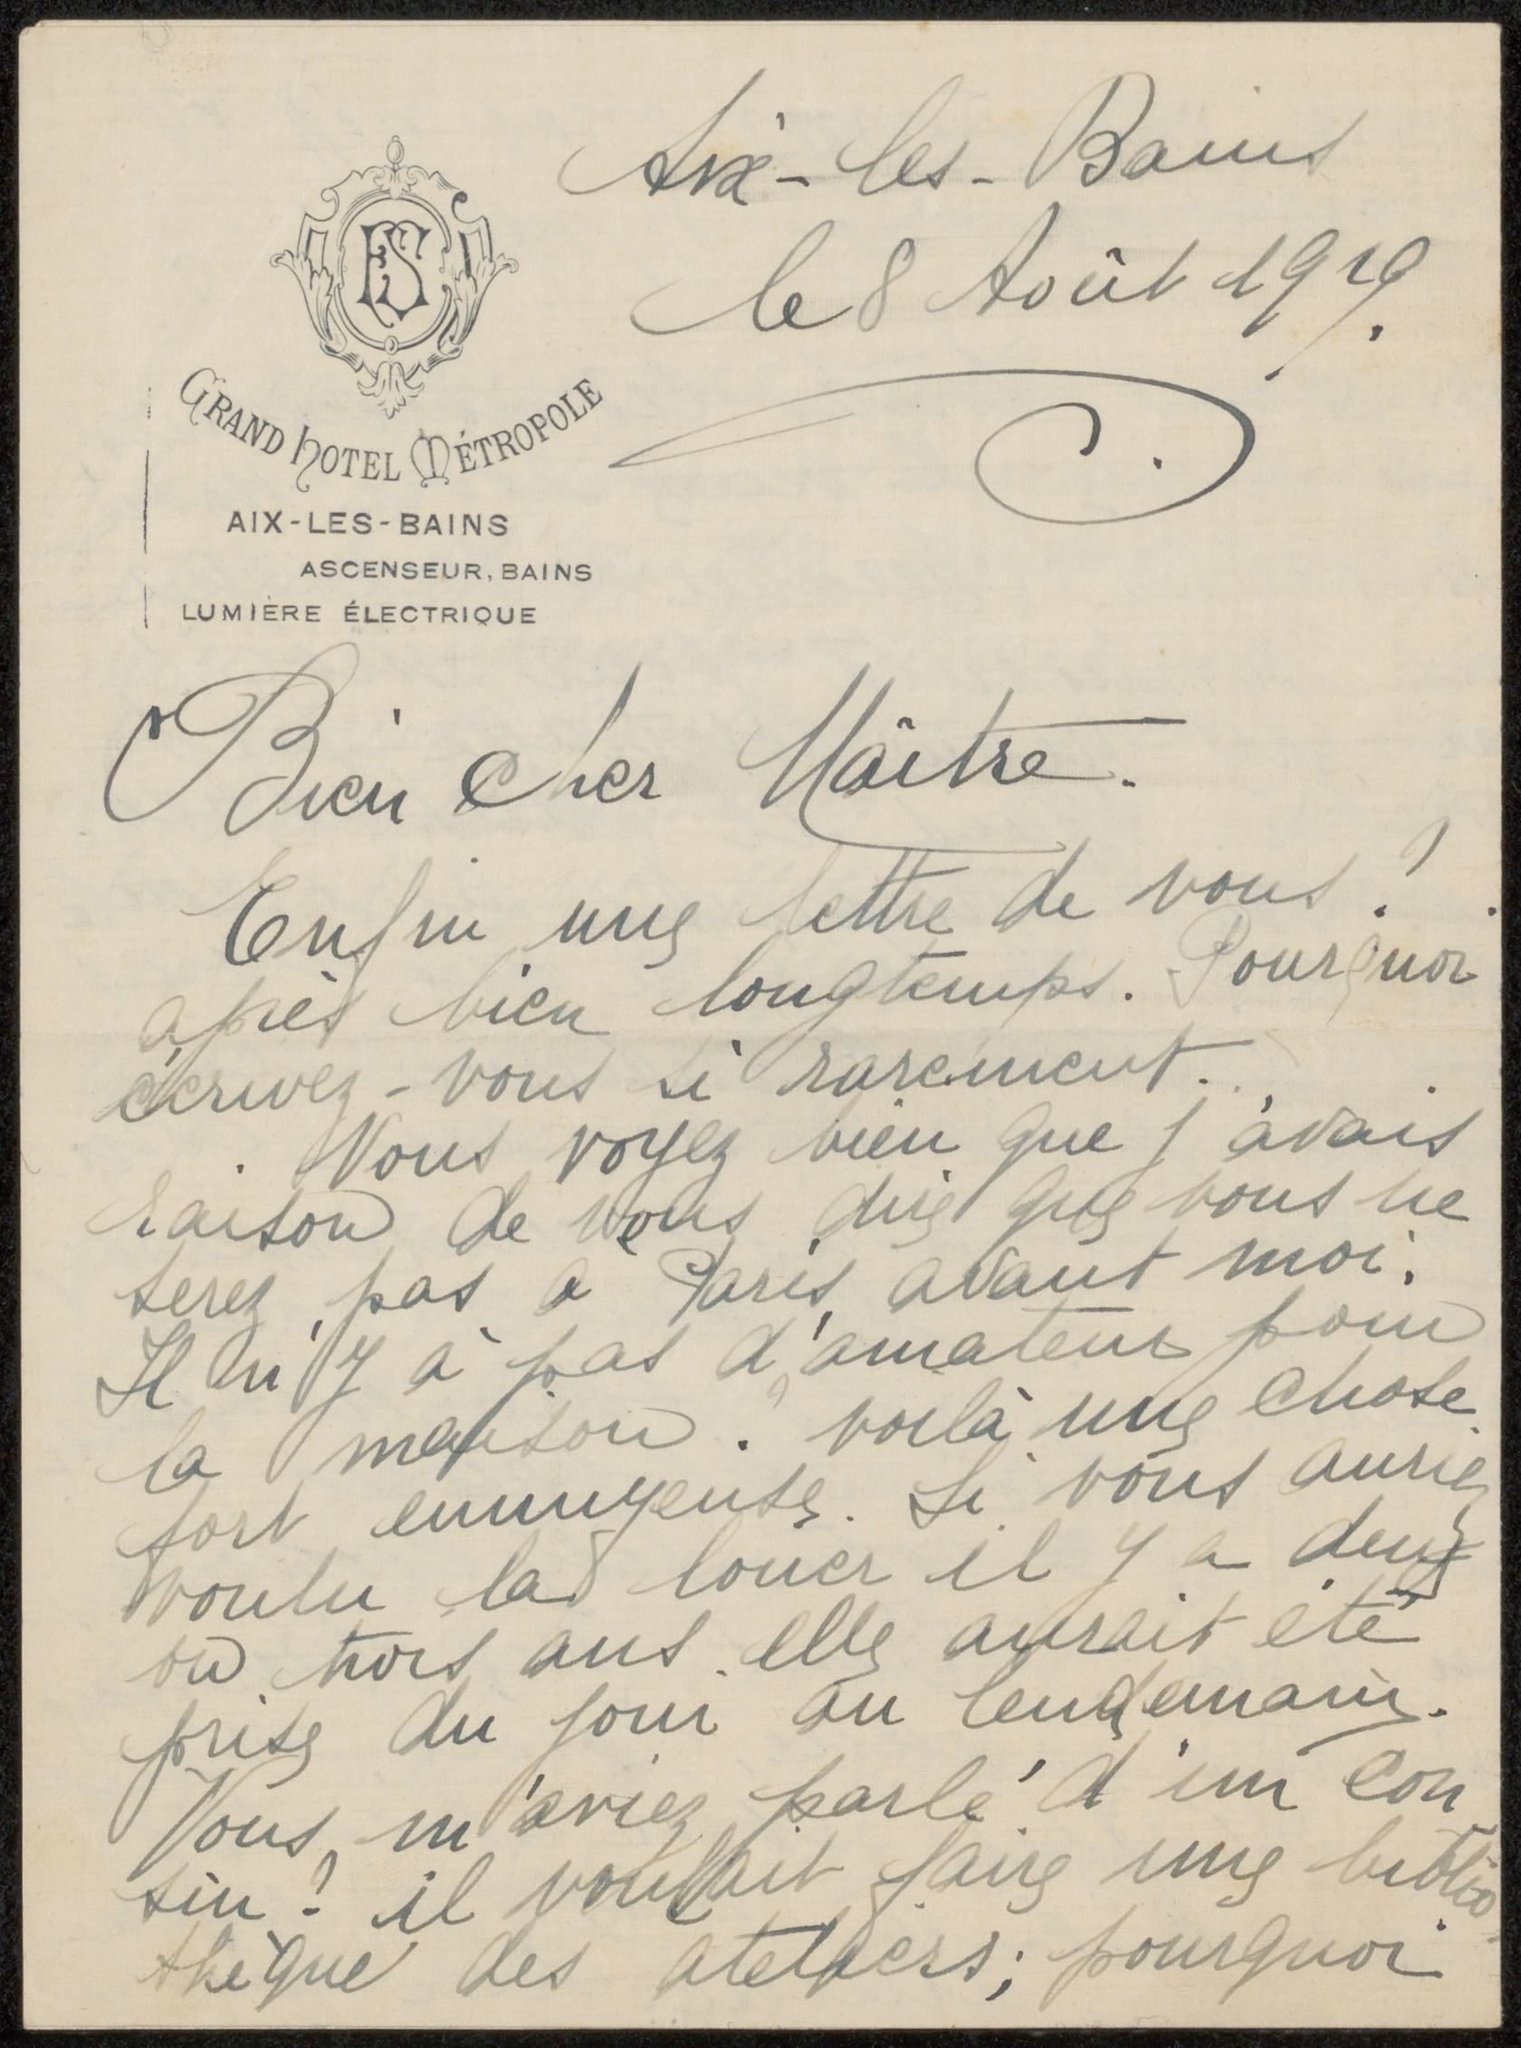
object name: letter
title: Brief aan Philip Zilcken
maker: rose imel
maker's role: draughtsman, painter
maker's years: 1901-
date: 1919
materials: ink, paper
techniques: pen, printing, writing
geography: aix-les-bains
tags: paris, print maker, draughtsman, sculptor, théophile alexandre steinlen, léonce bénédite, the hague, philip zilcken, artist's model, sitter, workshop, studio of the artist (in general)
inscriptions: collector's mark: ‘RPK’